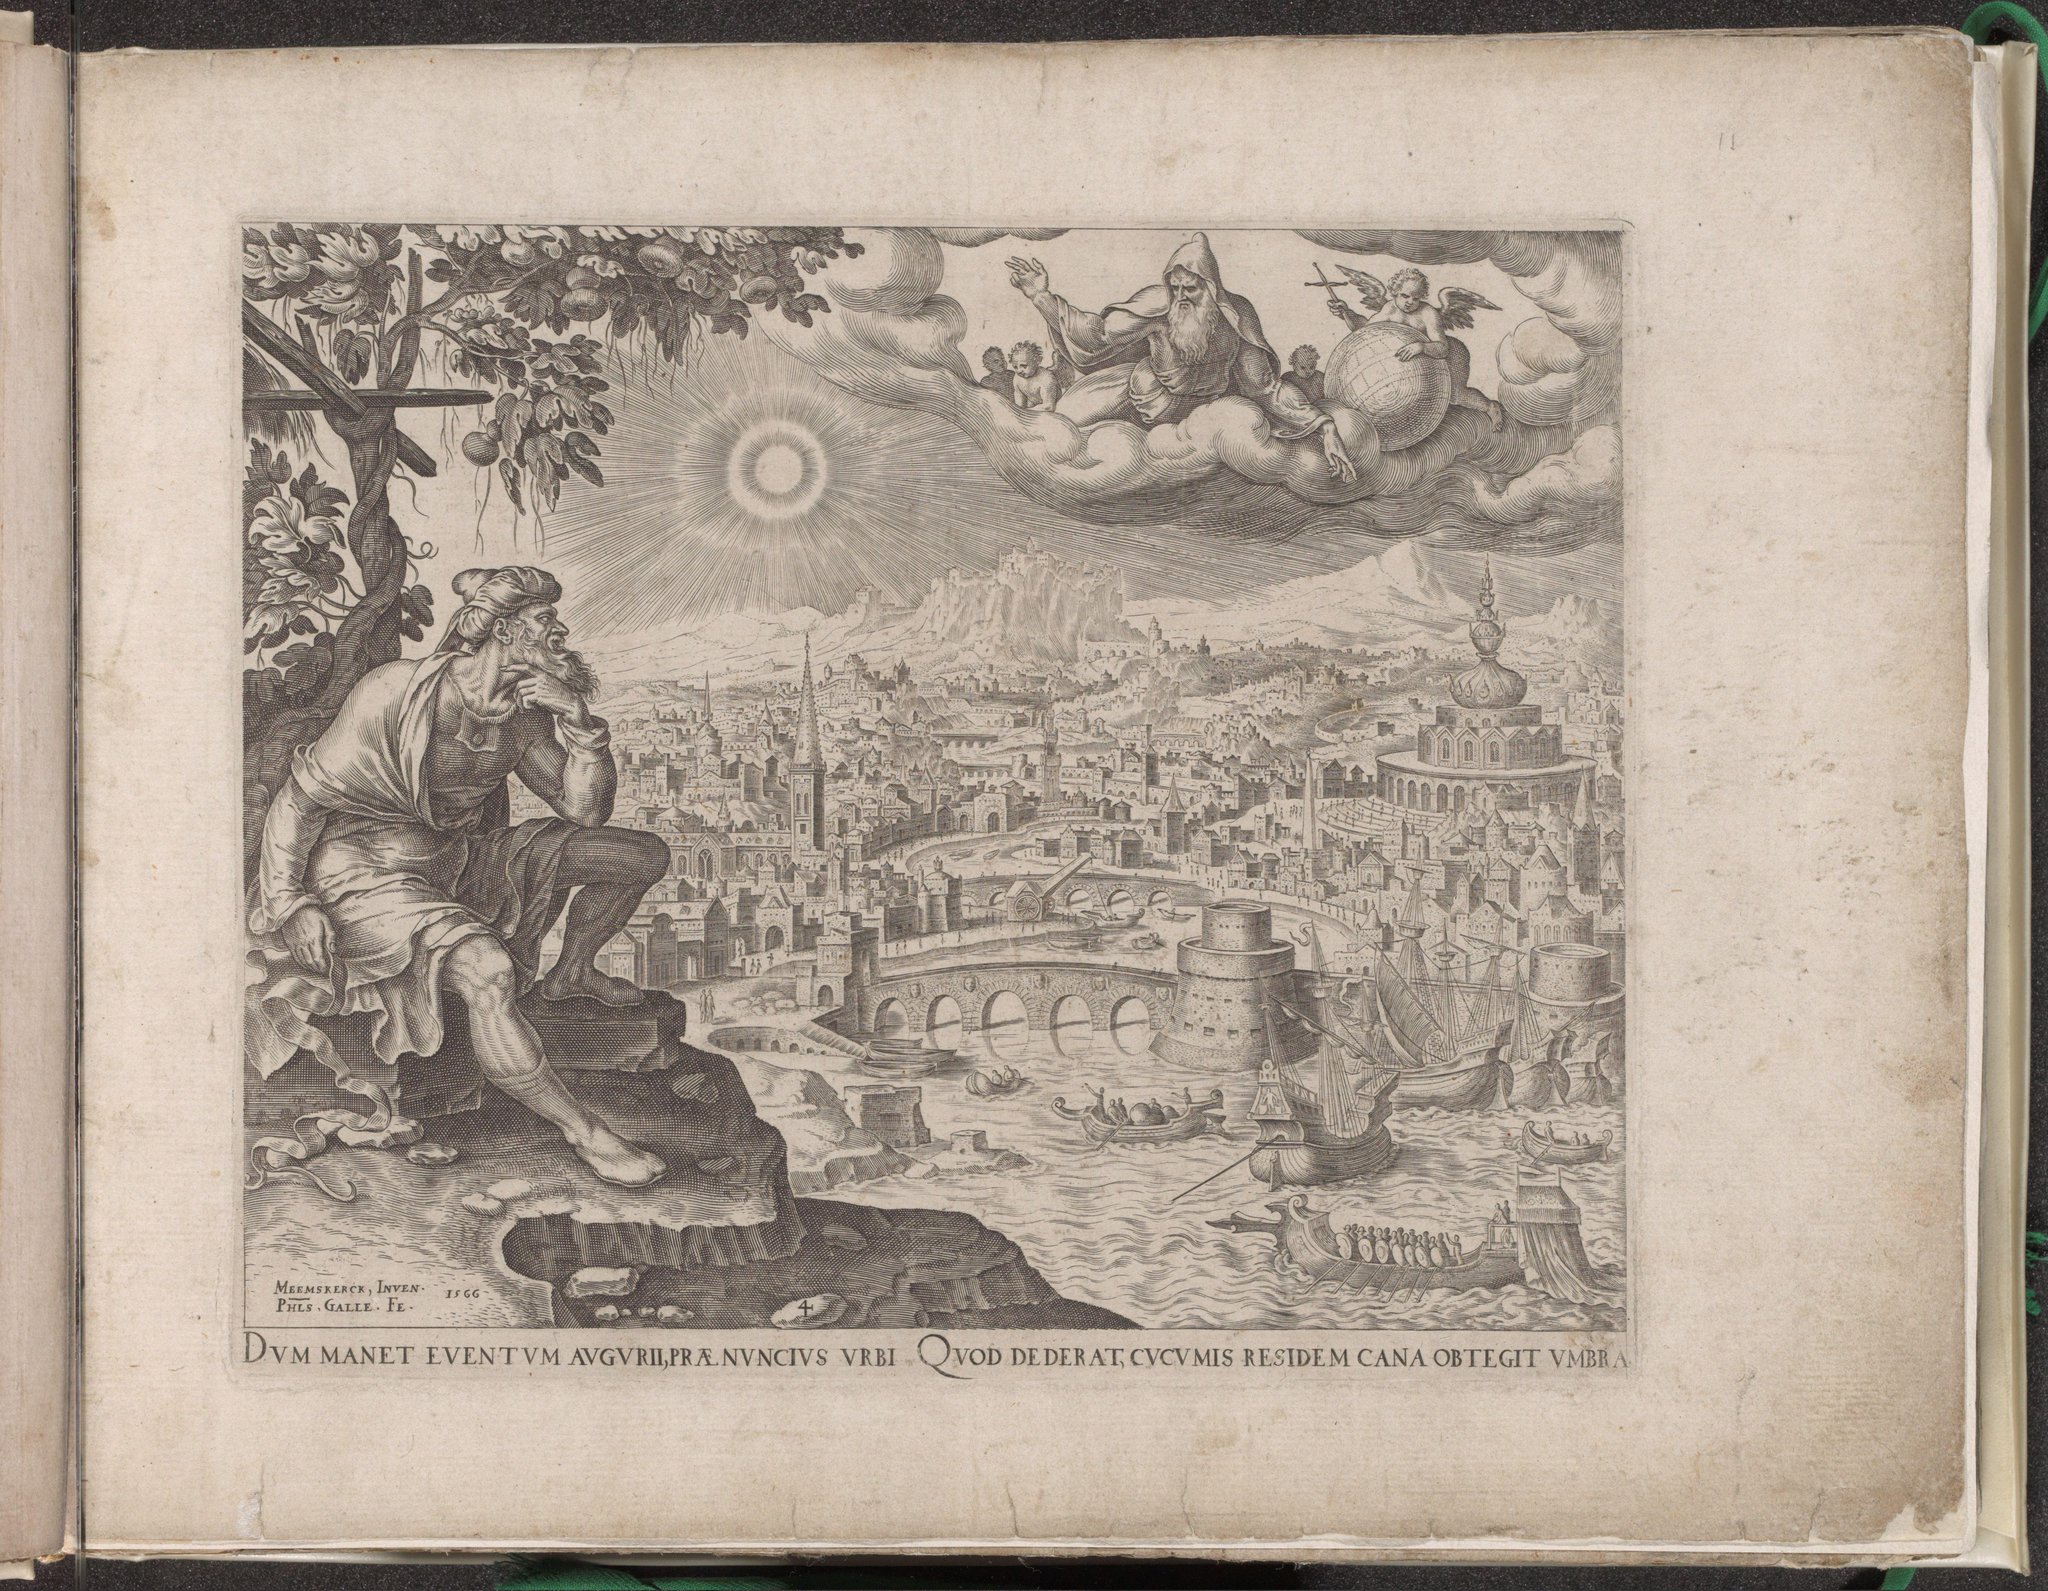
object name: print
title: Geschiedenis van Jona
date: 1566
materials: paper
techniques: engraving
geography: haarlem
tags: the prophet jonah withdraws from nineveh; he builds a booth and while enjoying the shade of a plant (gourd or vine) which god made grow for him, he awaits the destiny of the city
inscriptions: date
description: Jona zit op een rots boven de stad Nineve en wacht tot God de stad zal vernietigen. God heeft een wonderboom voor hem laten groeien, zodat hij in de schaduw kan zitten. Op de wolken verschijnt God. Onder de voorstelling een verklarende tekst in het Latijn. Deze prent maakt deel uit van een album.